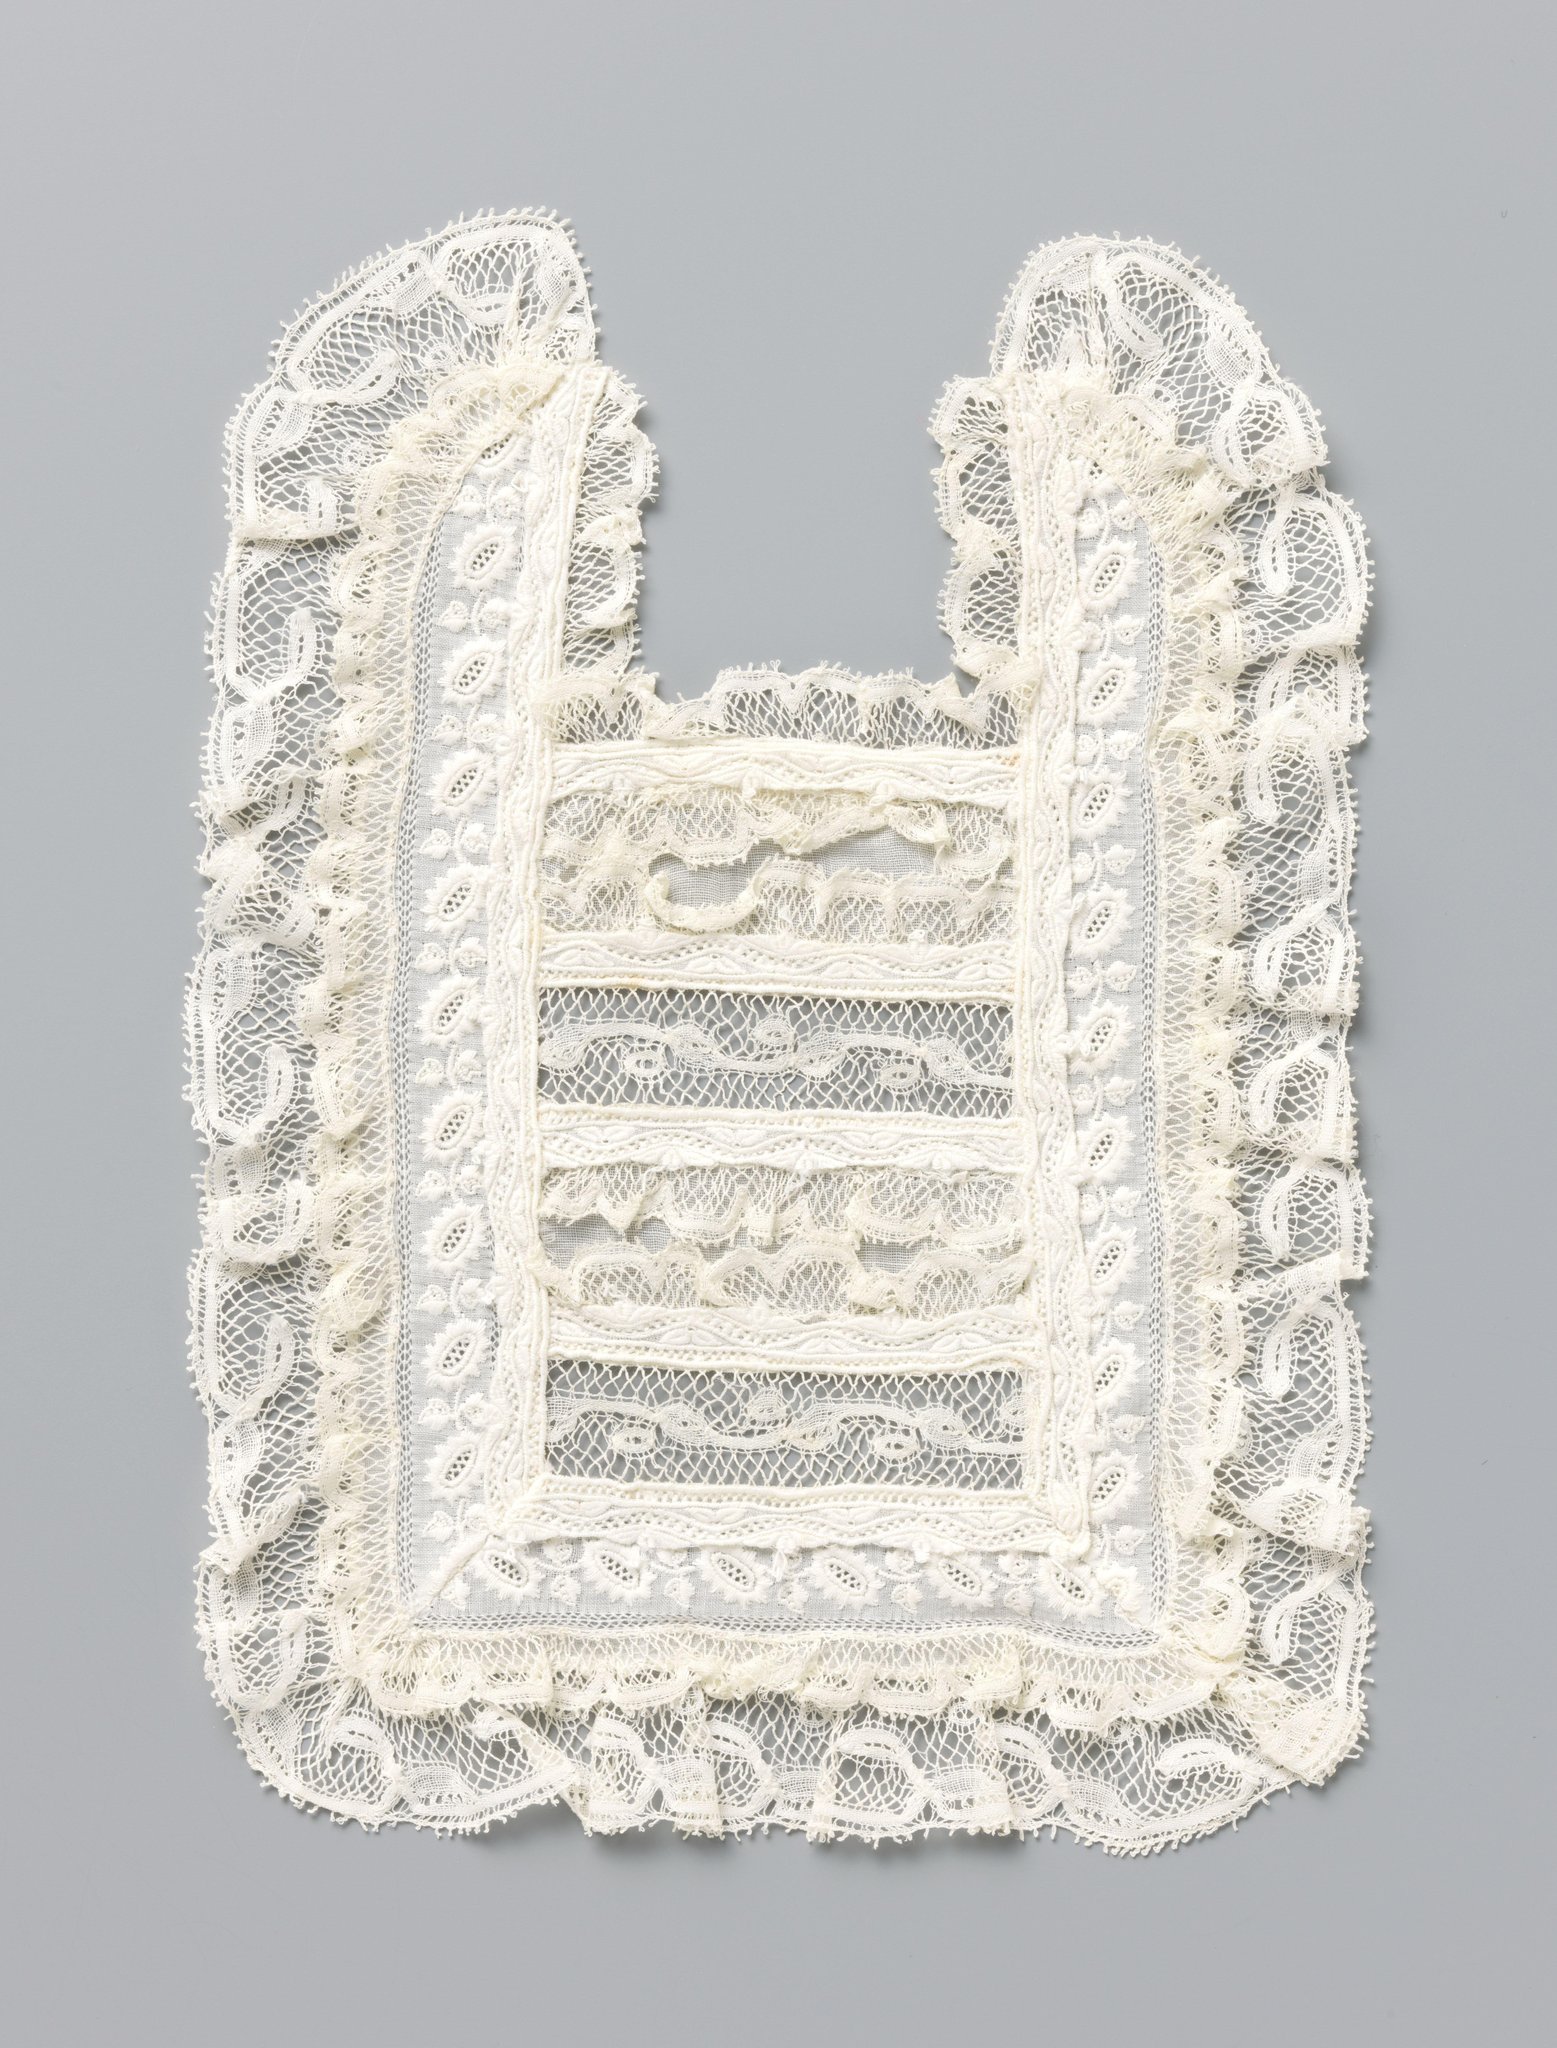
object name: bib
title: Slab van smal machinaal plumetis borduursel en Valenciennes-kant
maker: Anonymous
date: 1880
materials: lace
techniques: lace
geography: netherlands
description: Bavetje van smal machinaal plumetis borduursel, tusschenzetsels en kant van Valenciennes met rondom een smalle en een brede strook Valenciennes-kant.